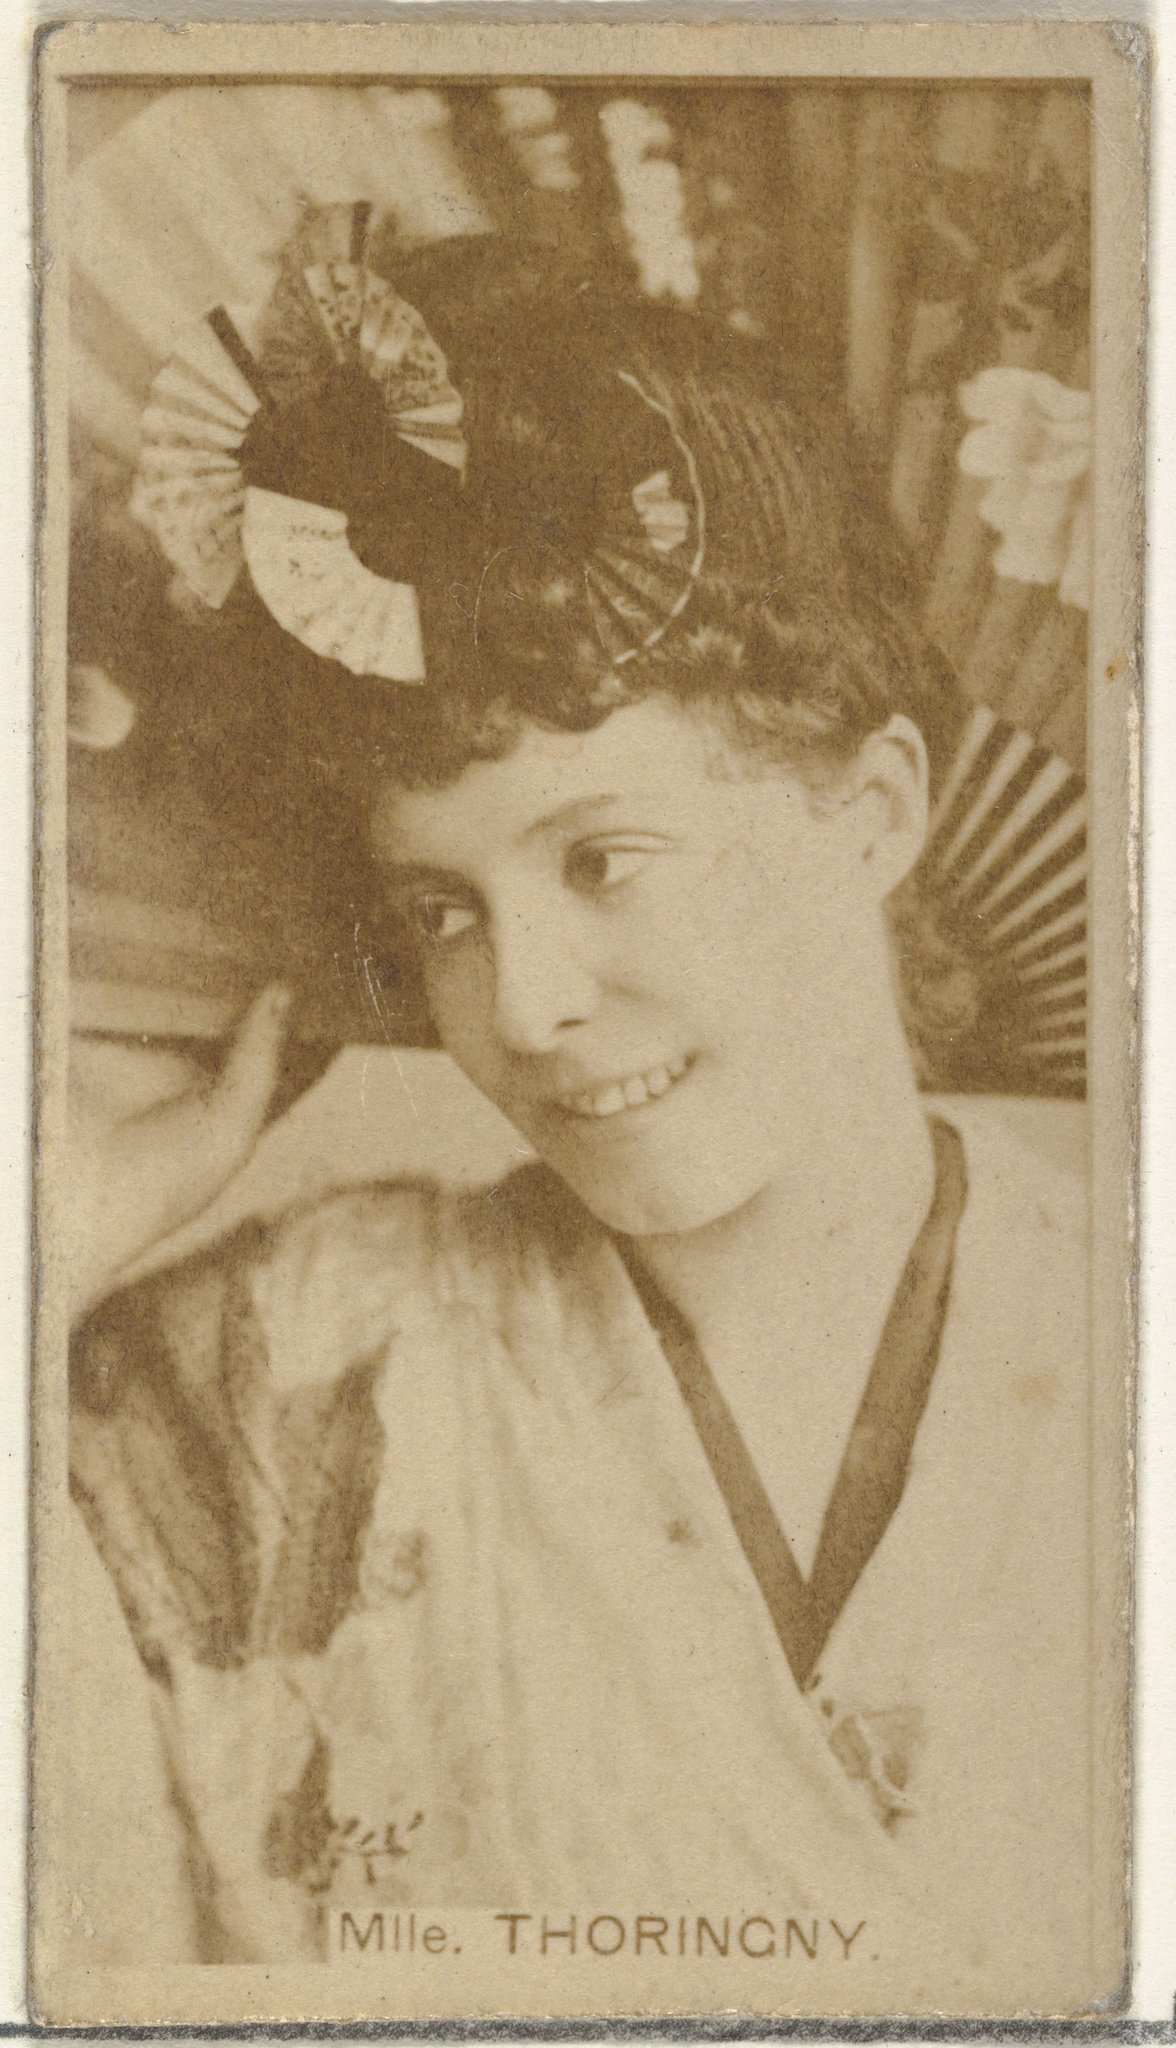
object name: photograph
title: Mlle. Thoringny, from the Actors and Actresses series (N145-8) issued by Duke Sons & Co. to promote Duke Cigarettes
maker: w. duke, sons & co.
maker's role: publisher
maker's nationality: american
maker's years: 1870-1920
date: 1891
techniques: albumen silver print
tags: portraits,women,actresses